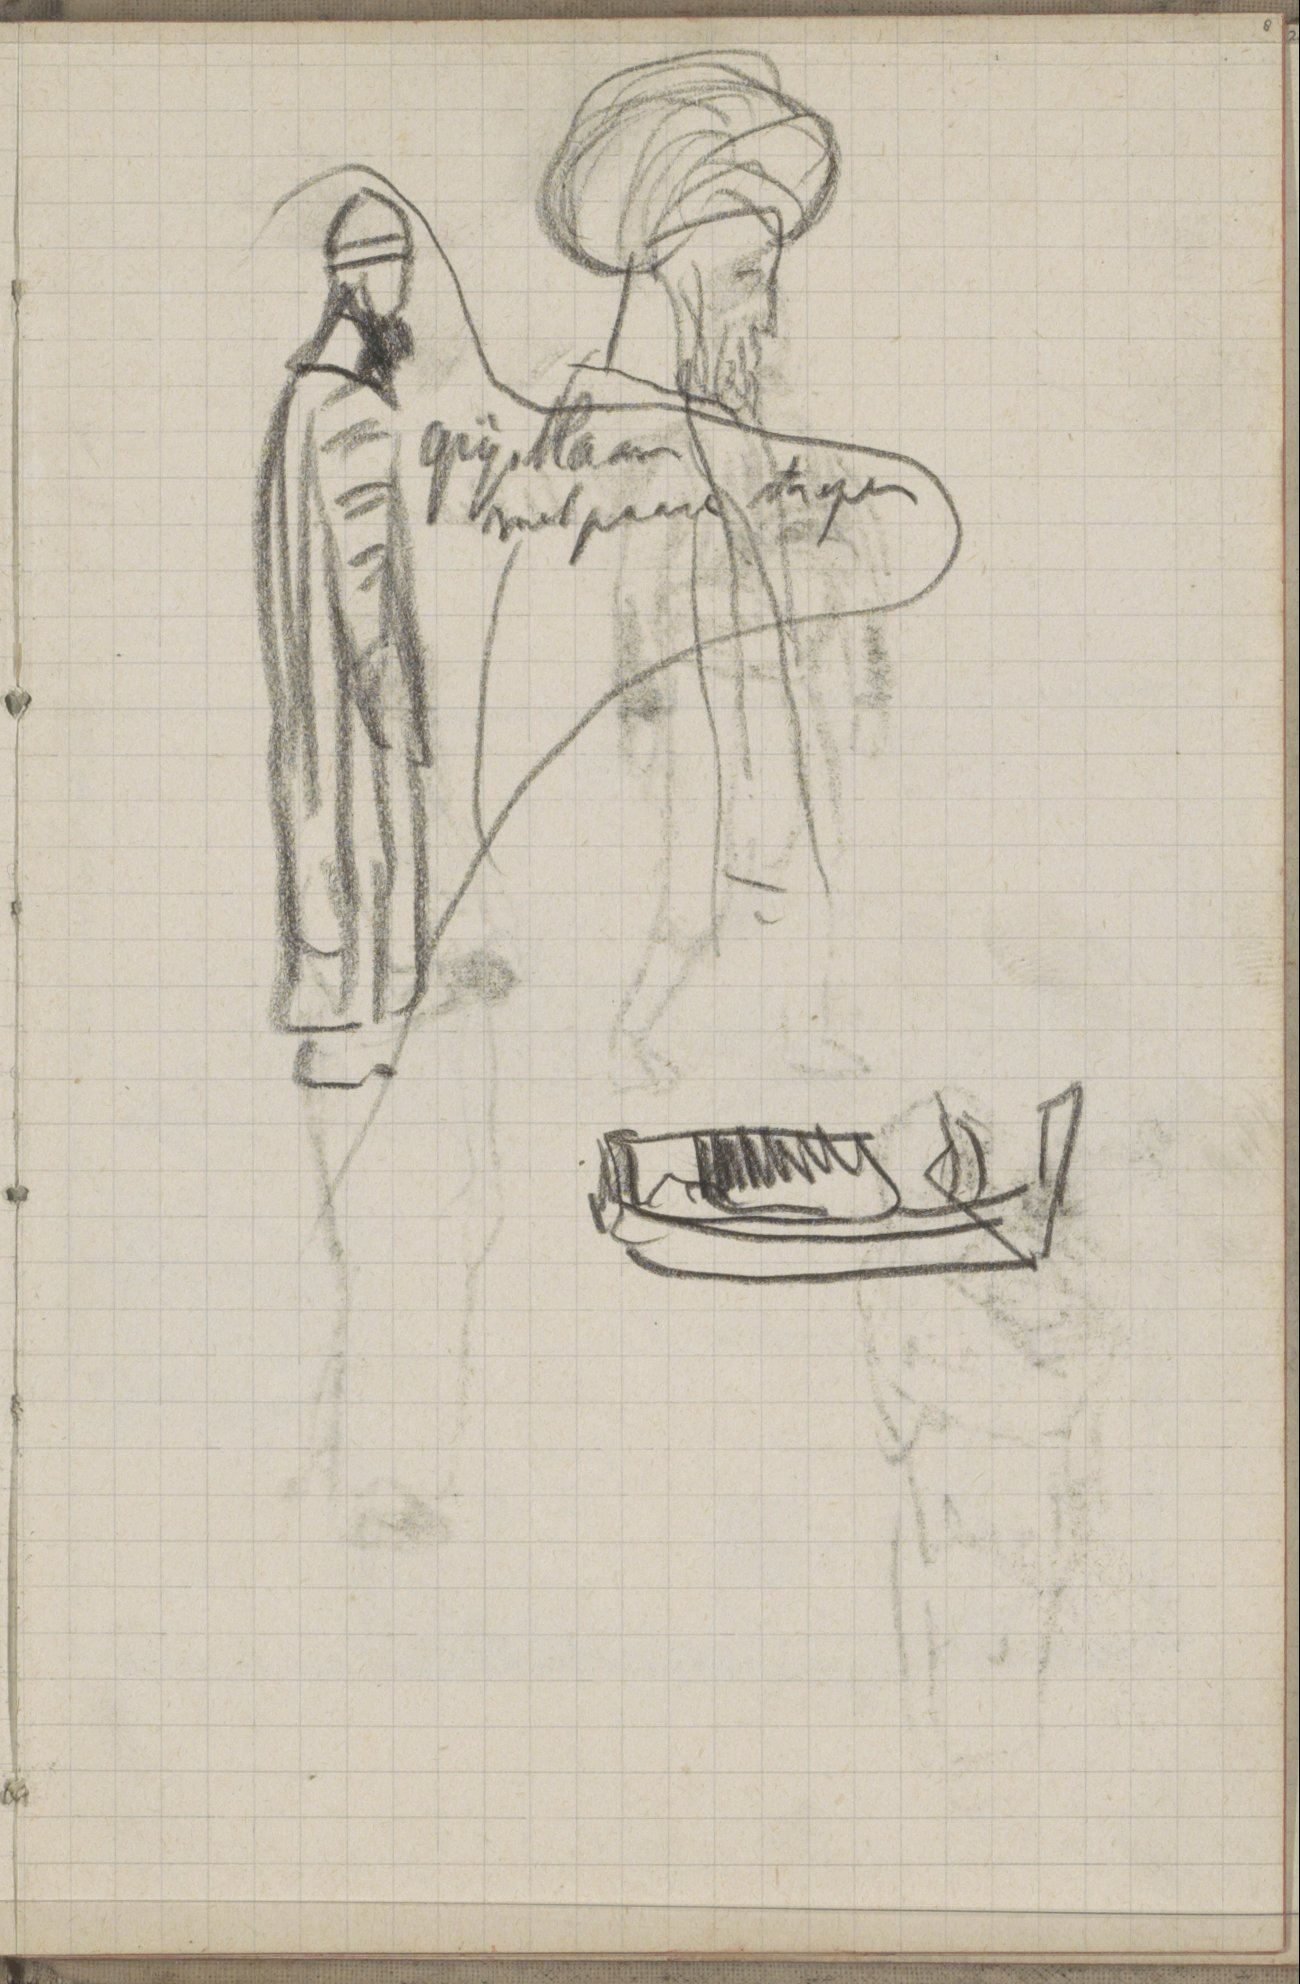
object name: sketchbook leaf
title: Studieblad, onder andere met een man in oosterse kleding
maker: marius bauer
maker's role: draughtsman, print maker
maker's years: 1867-1932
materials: chalk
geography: istanbul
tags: asiatic races and peoples, standing figure, adult man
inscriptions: kleurnotitie, handgeschreven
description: Pagina 8 uit een schetsboek met 54 bladen